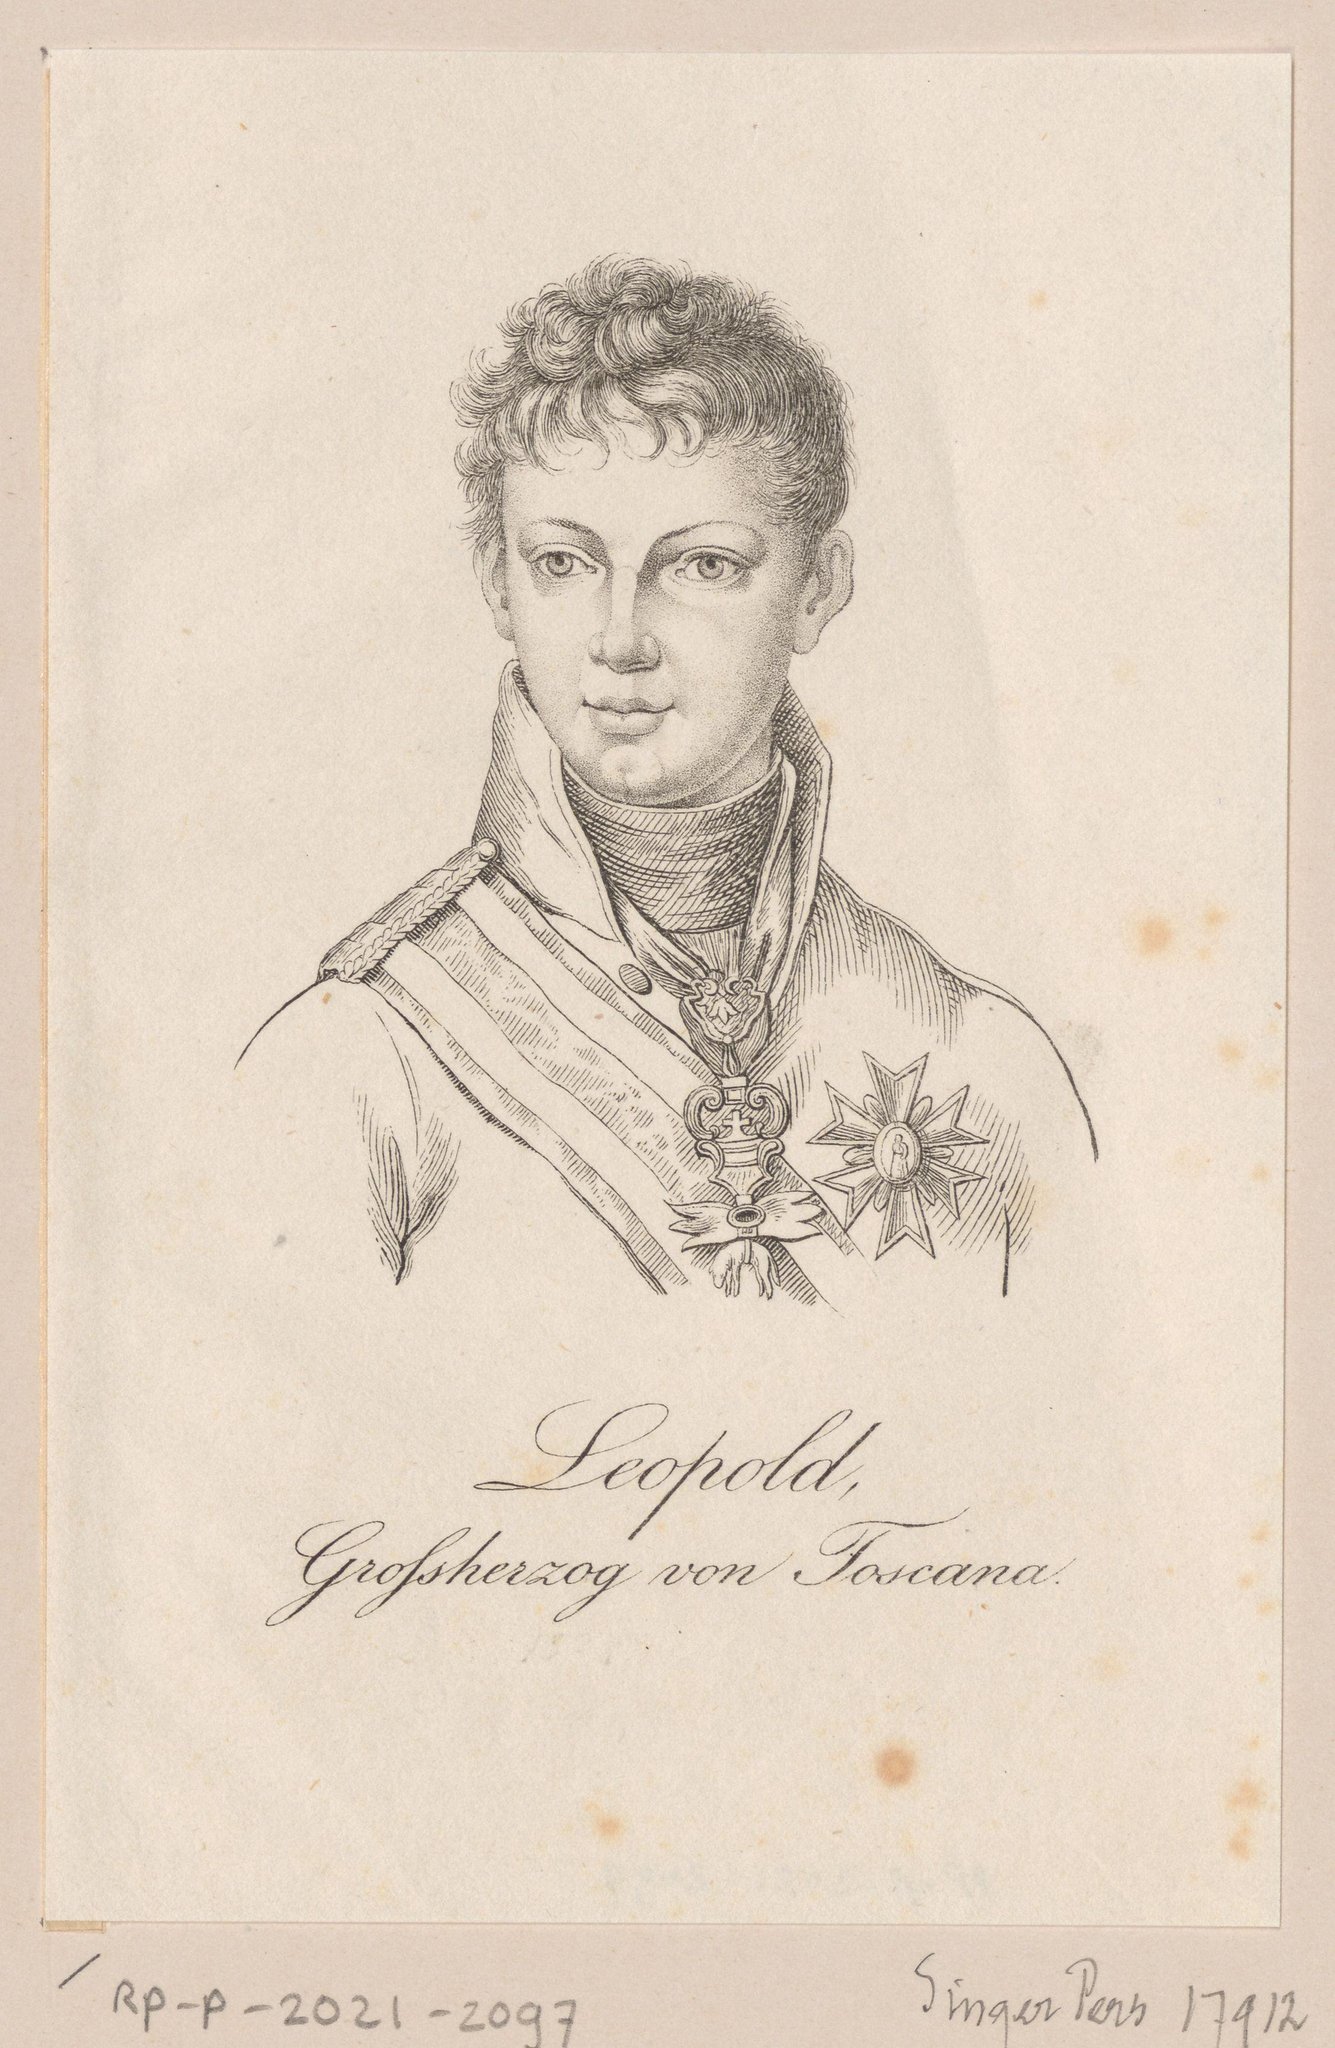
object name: print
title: Portret van Leopold II van Toscane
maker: Anonymous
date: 1824-1859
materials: paper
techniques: etching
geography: germany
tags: rome, historical persons, knighthood order of the golden fleece - insignia of a knighthood order, e.g.: badge, chain (with name of order)